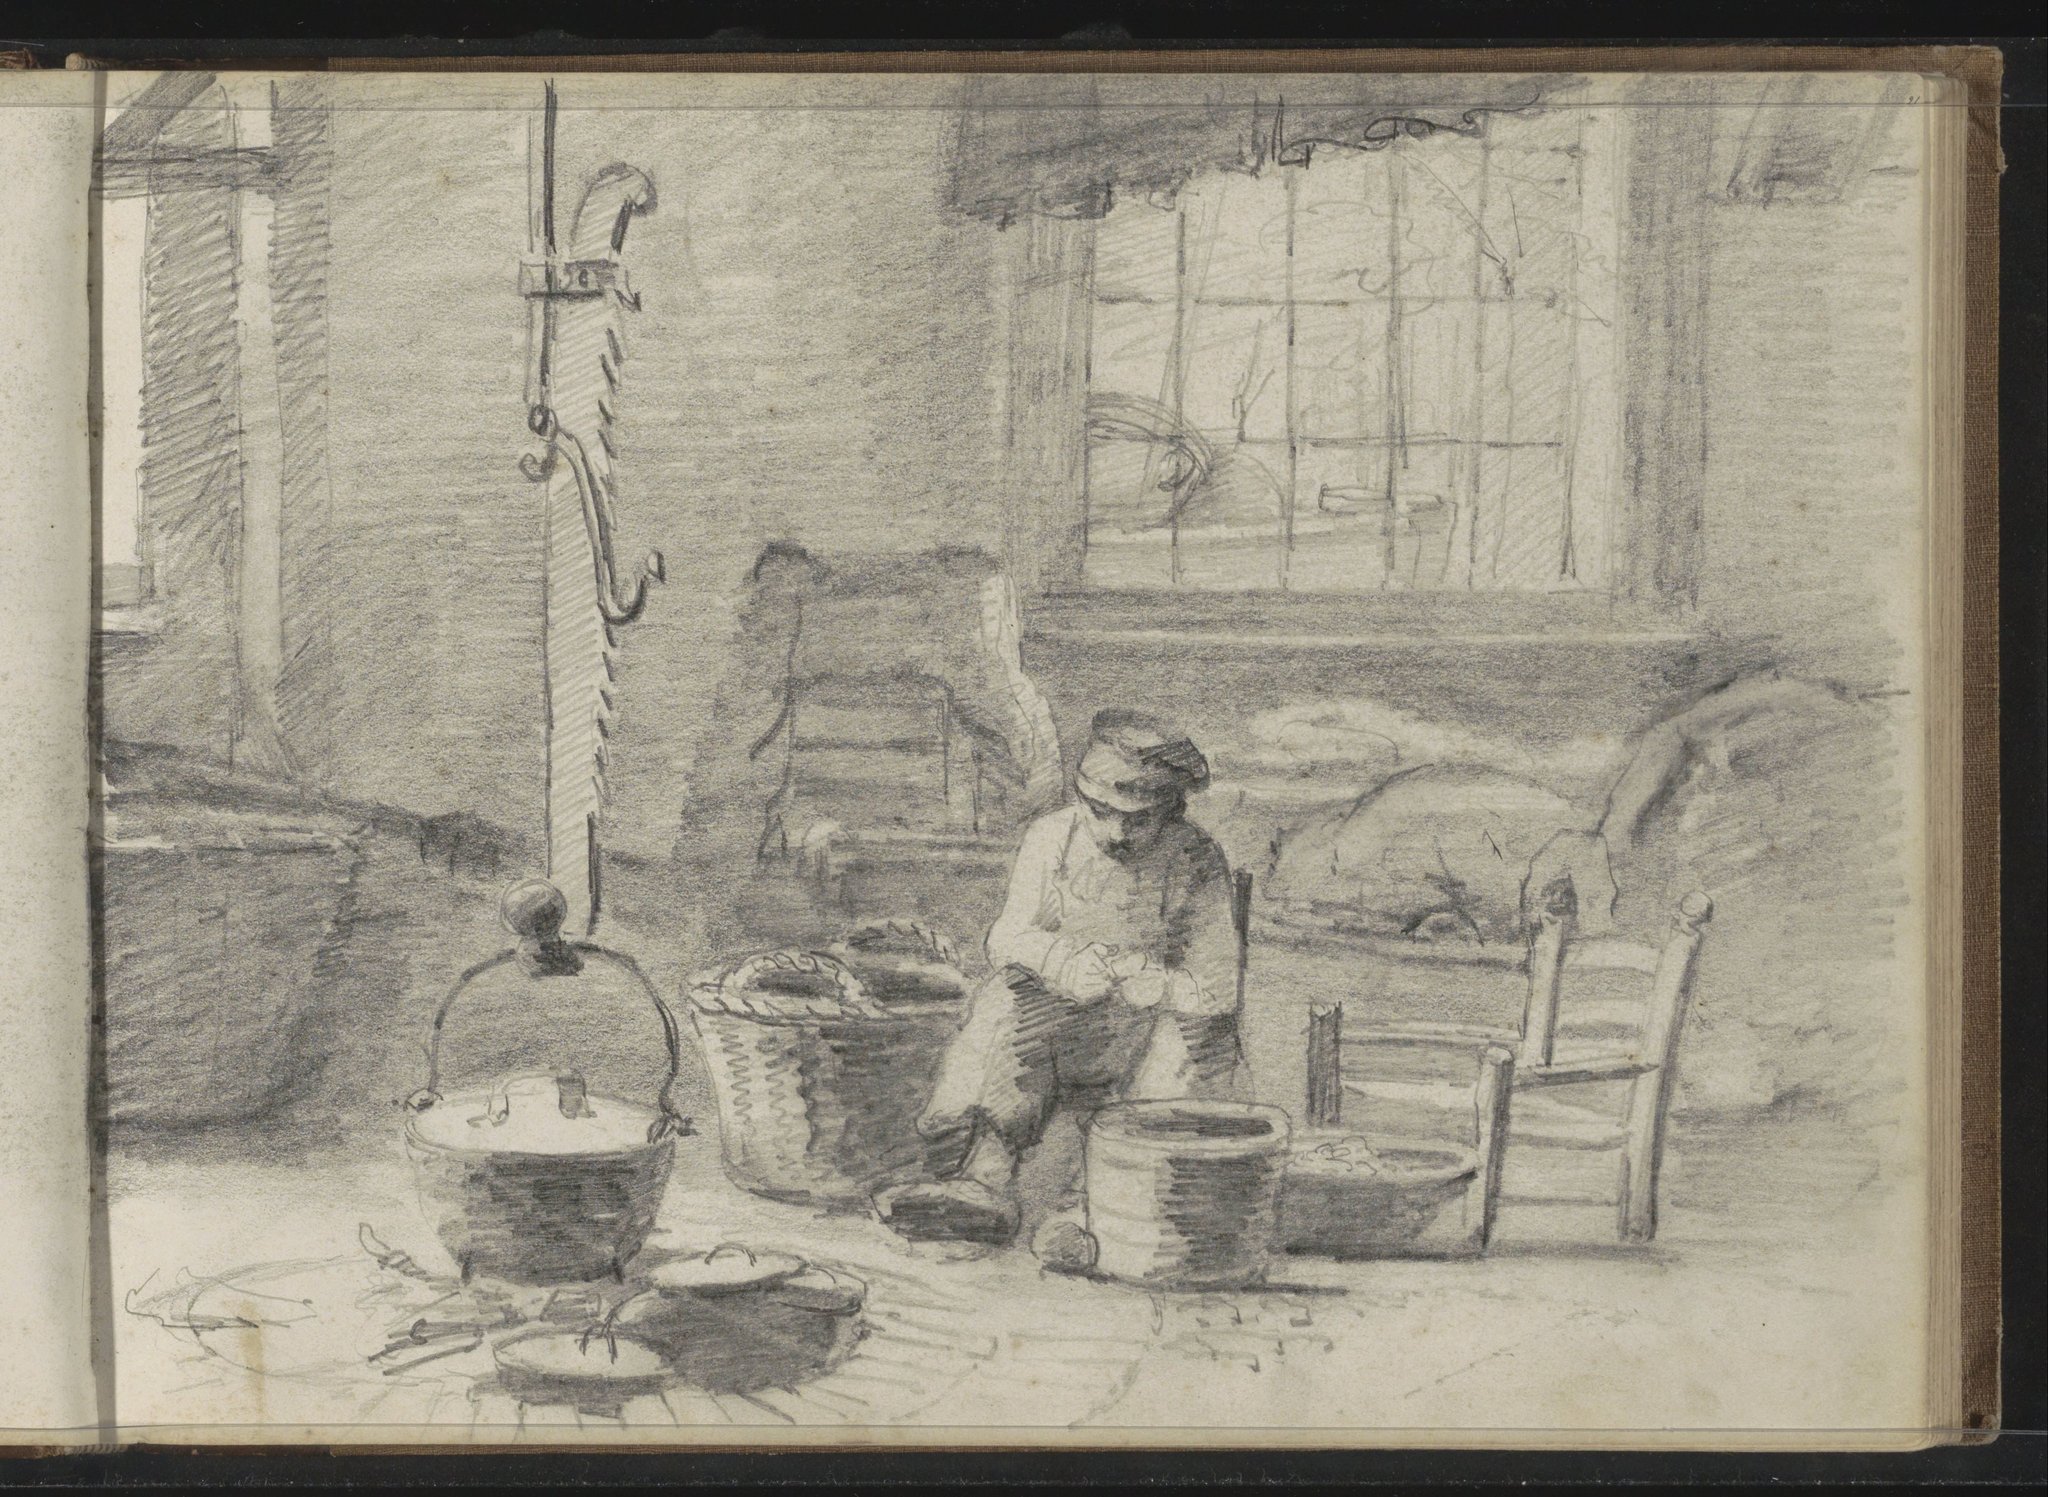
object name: sketchbook leaf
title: Boereninterieur met een aardappelschillende jongen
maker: hendrik valkenburg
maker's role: draughtsman, painter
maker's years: 1826-1896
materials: paper, pencil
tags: boy (child between toddler and youth), cottage - aa - civic architecture: inside, cleaning (food)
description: De jongen zit op een houten stoel bij een venster. Naast hem hangt een pot boven het vuur. Blad 21 recto uit een schetsboek met 77 bladen.